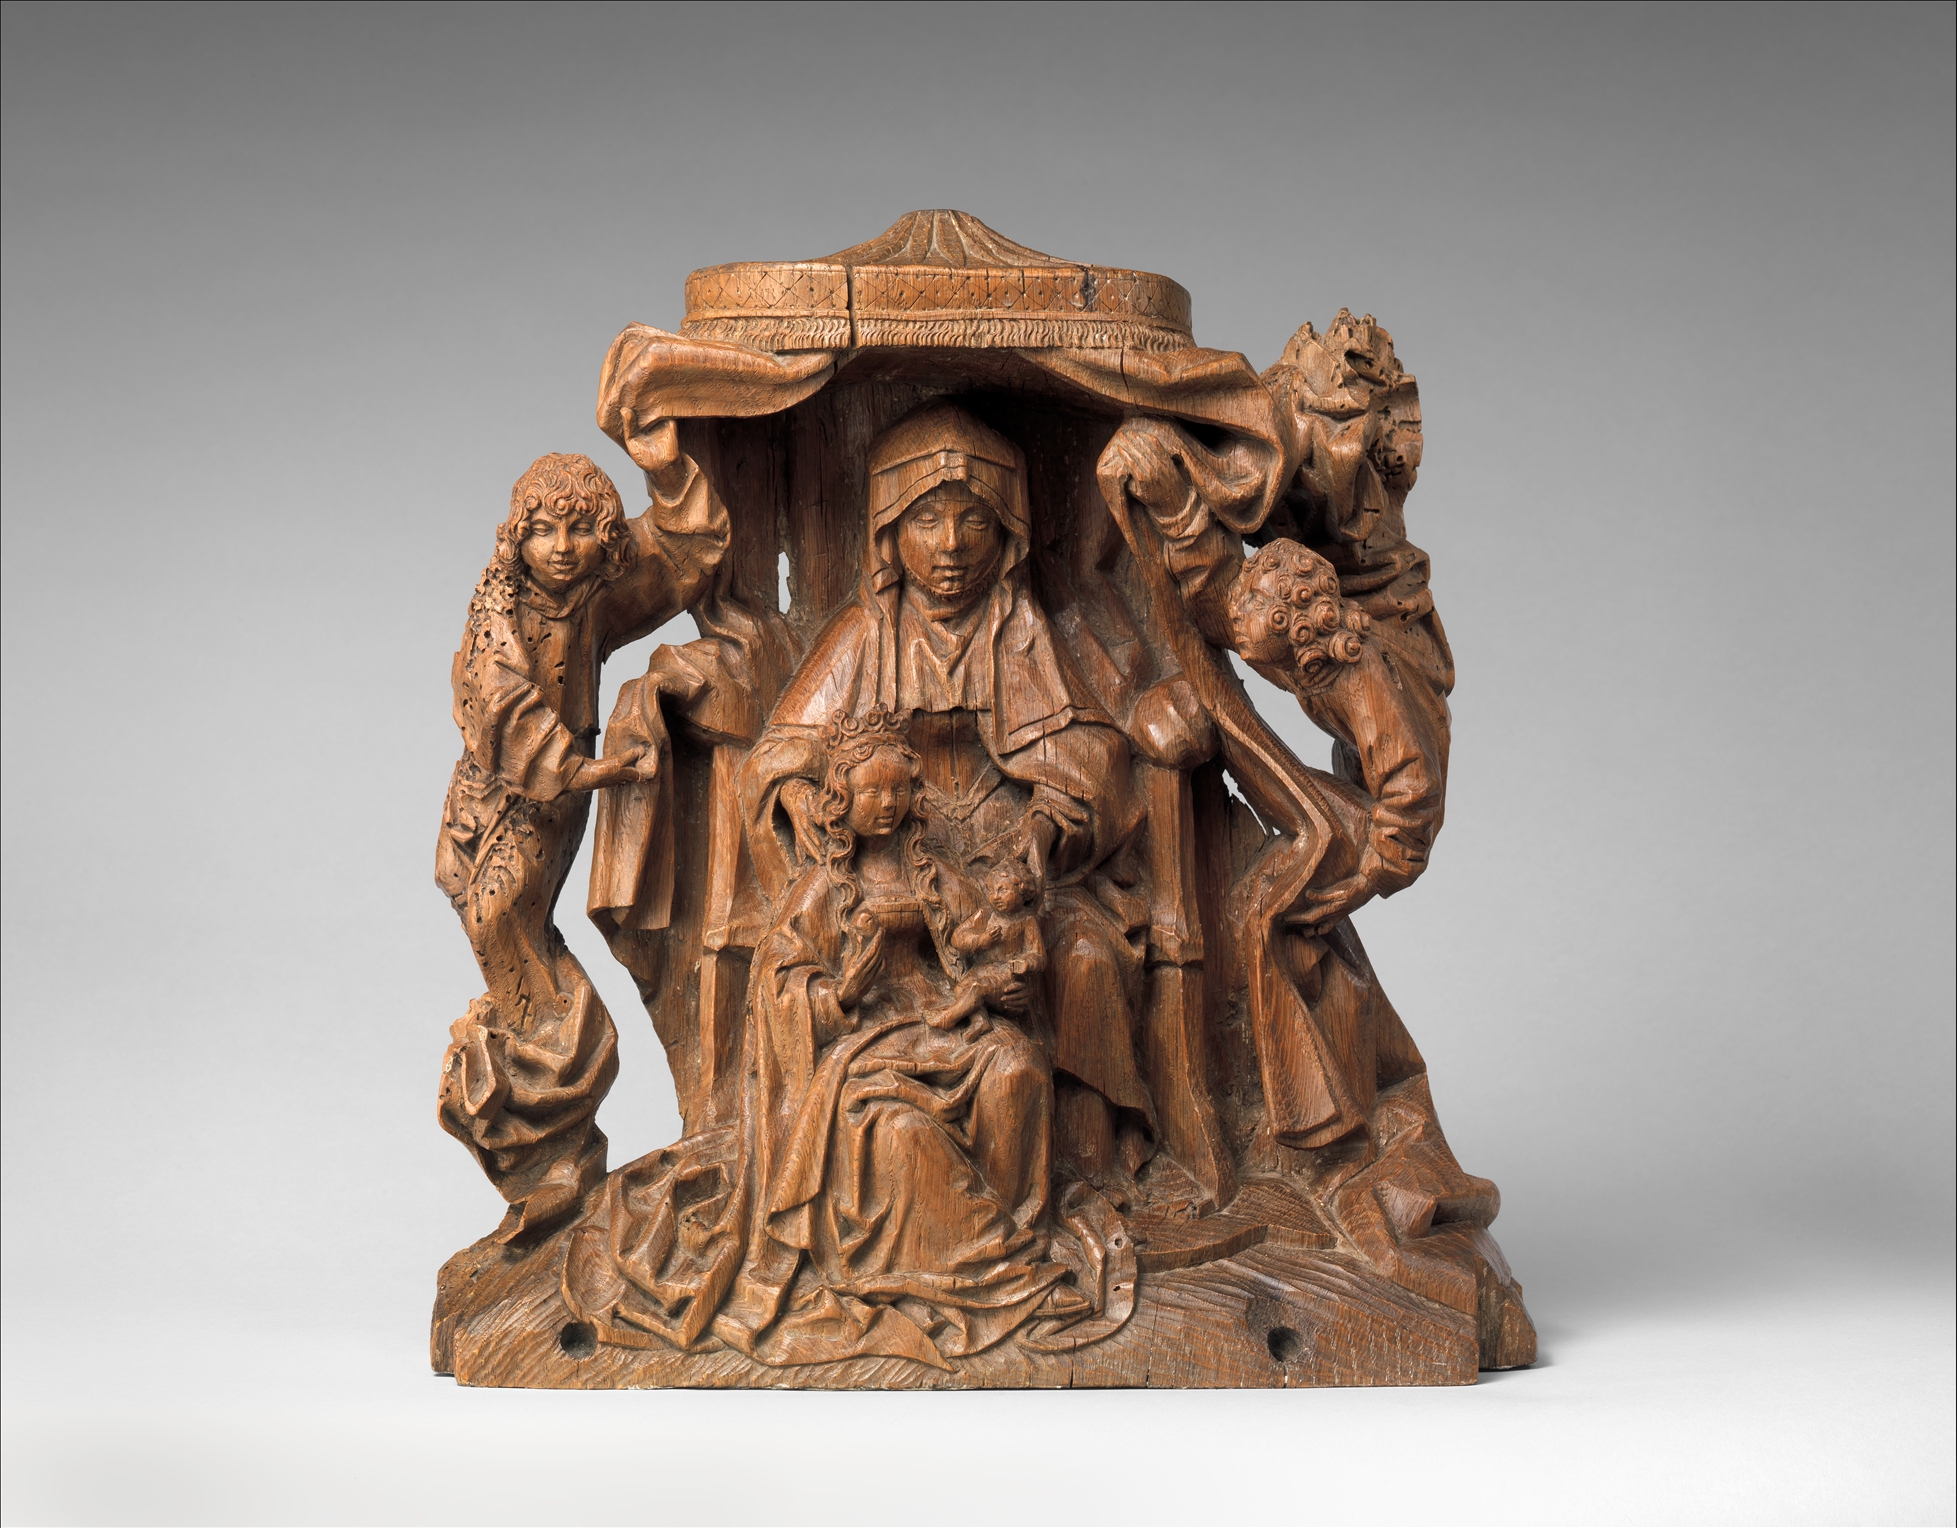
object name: relief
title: Saint Anne with the Virgin and Child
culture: german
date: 1475-1500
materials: wood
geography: germany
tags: madonna and child